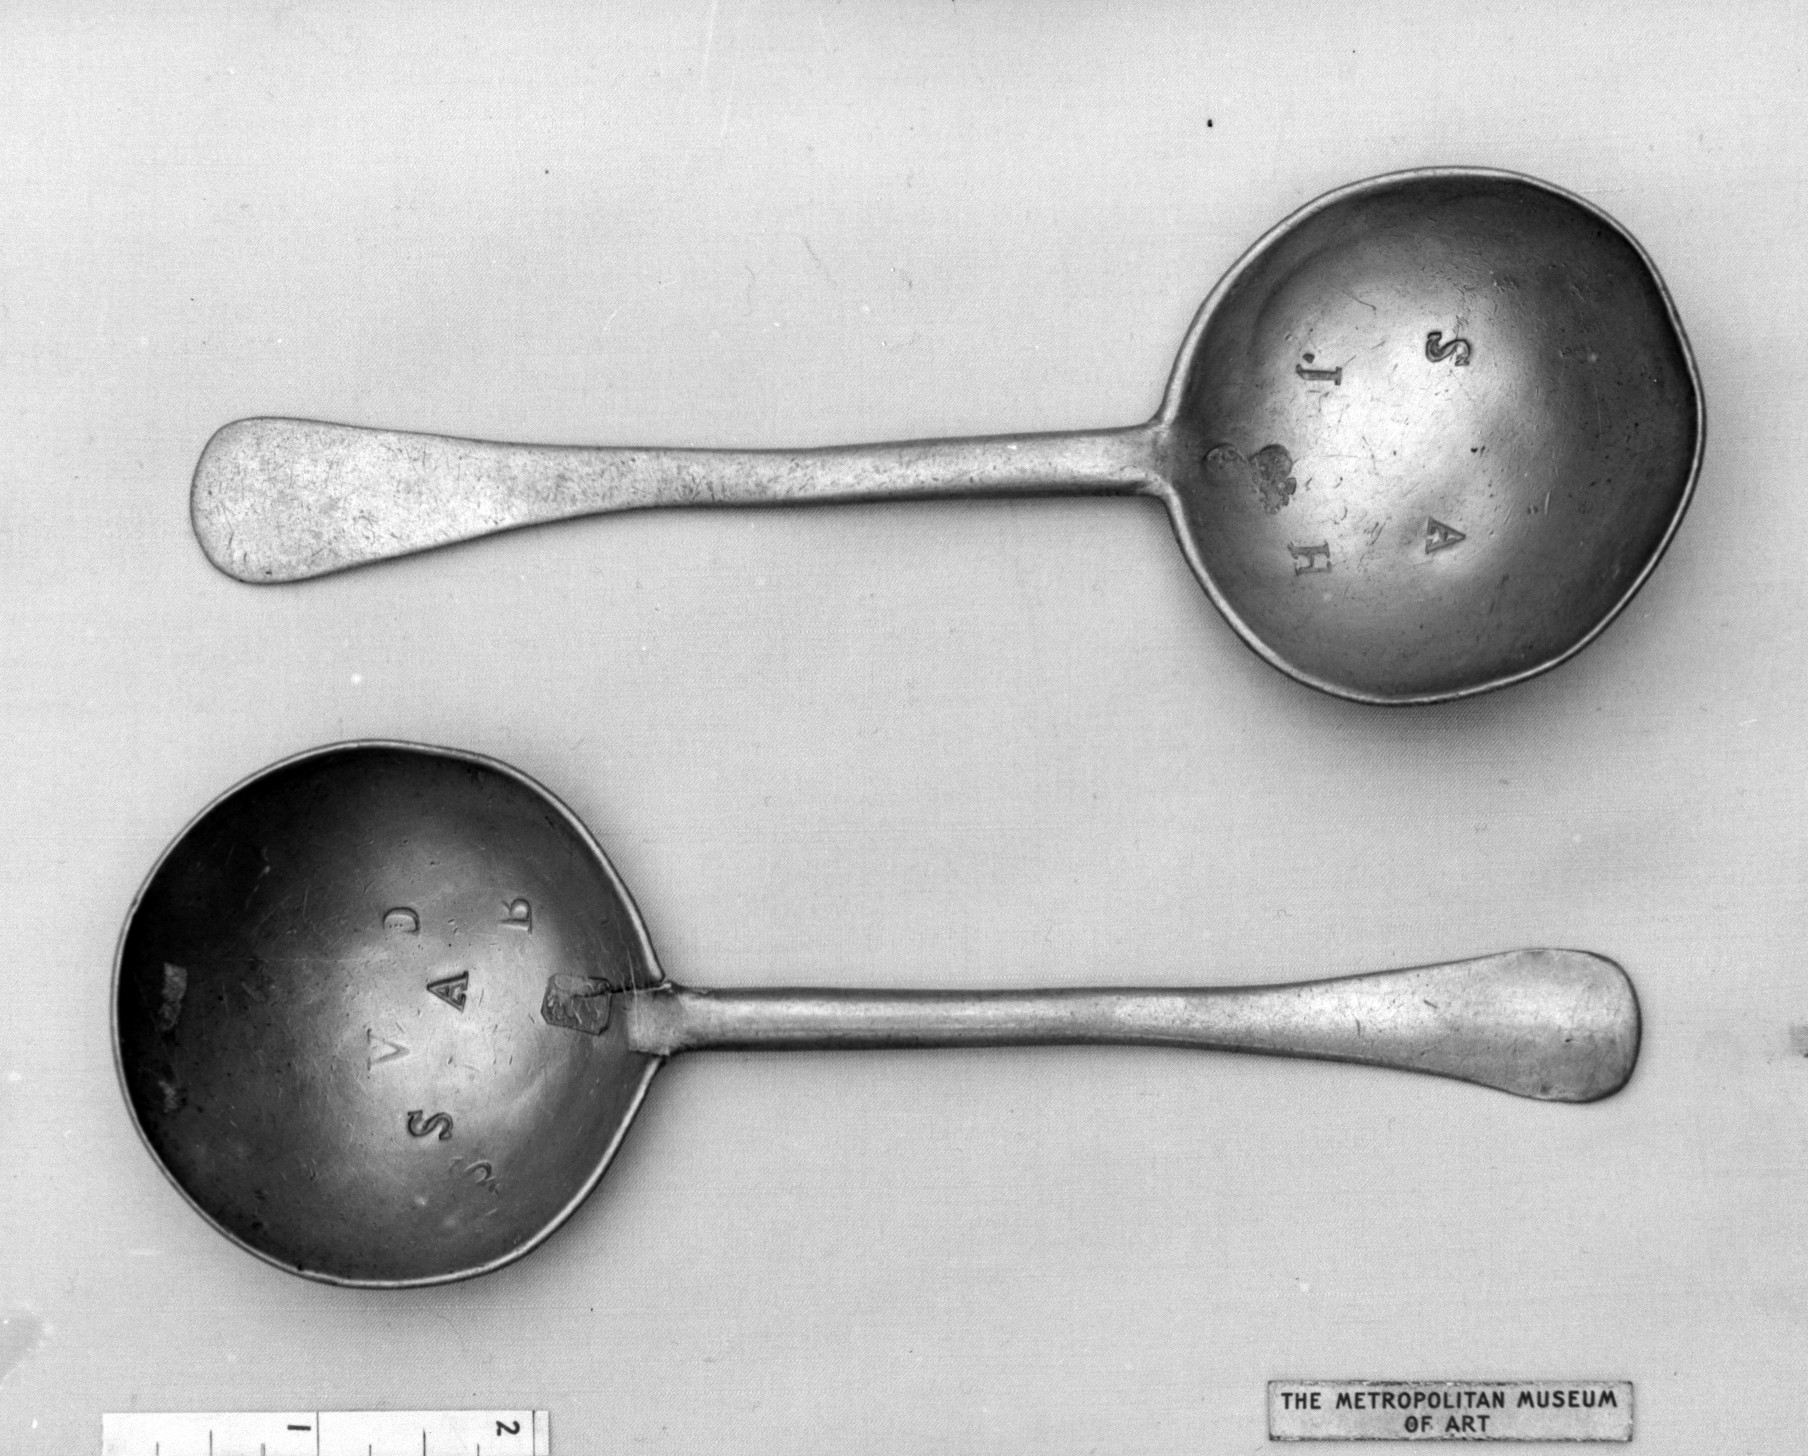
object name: spoon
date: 1701-1800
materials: pewter